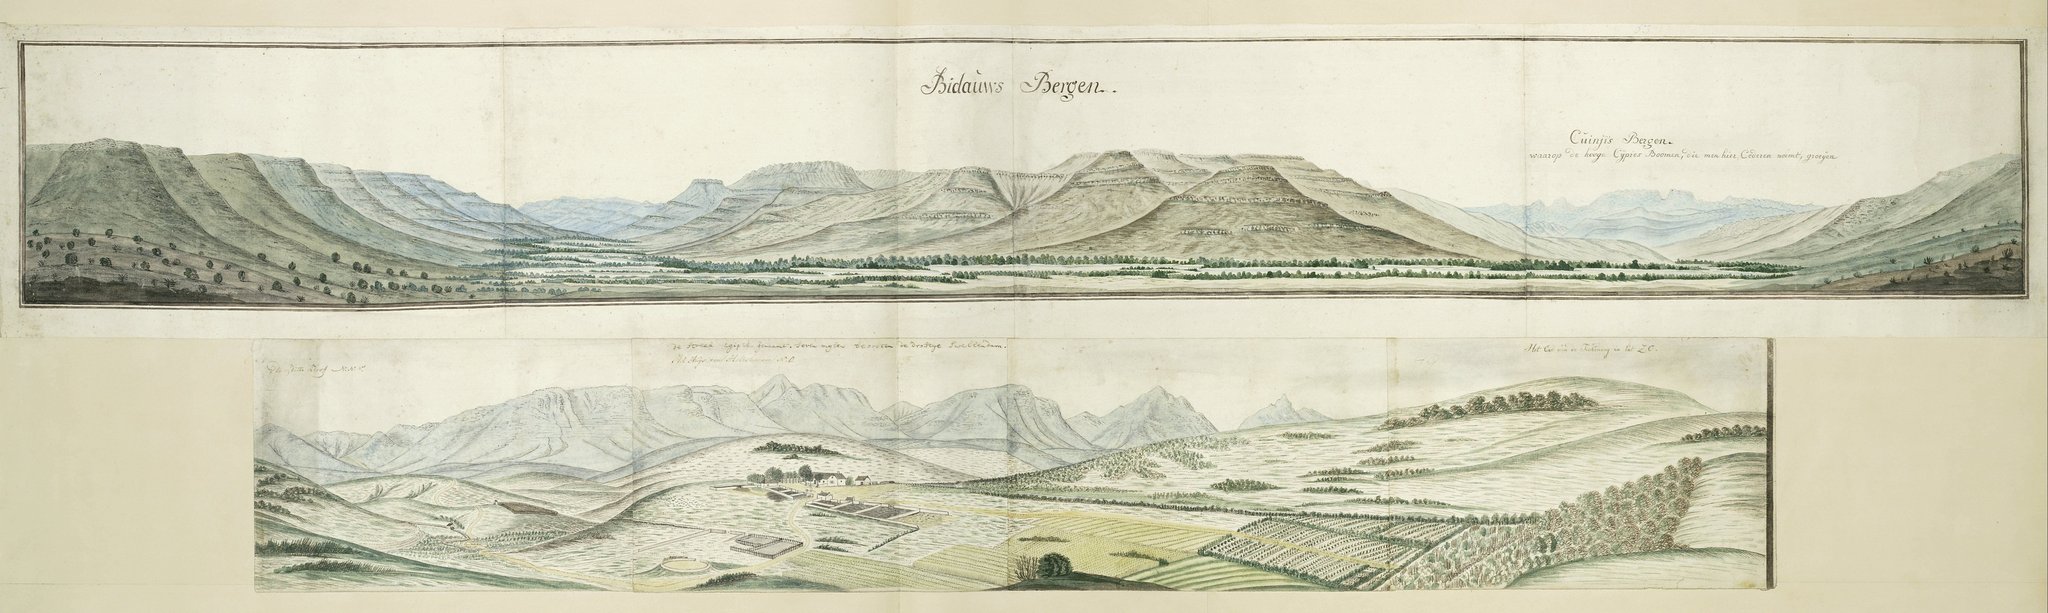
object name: panorama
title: Panorama of the district known as Egypt, east of Swellendam, seen from the south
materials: ink, paper, pencil, watercolor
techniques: brush, pen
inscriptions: annotation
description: Oorspronkelijk in omslag van roodkleurig halfleer en roodgemarmerd plat, dorso met ribben en goudopdruk; 71 x 99 x 6 cm.